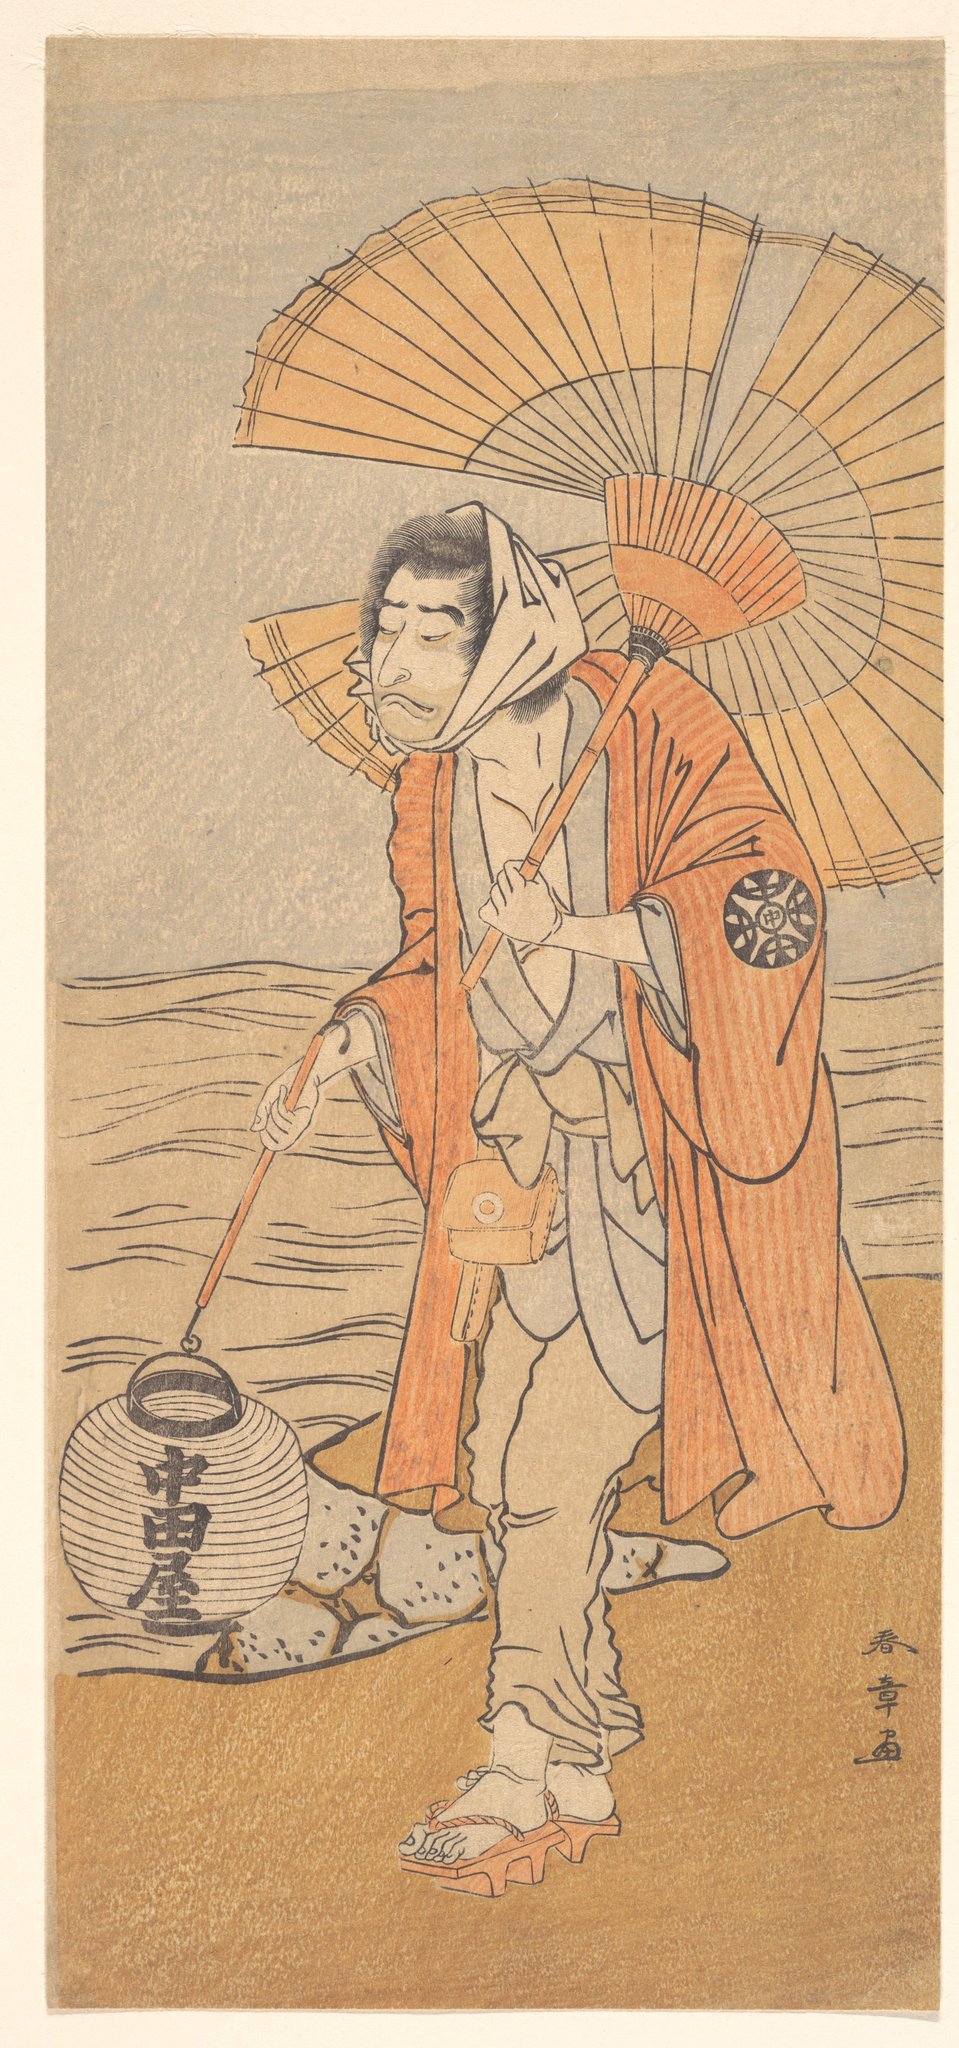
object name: woodblock print nishiki e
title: The Actor Nakamura Nakazo I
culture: japanese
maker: katsukawa shunshō 勝川春章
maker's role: artist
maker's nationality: japanese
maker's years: 1726-1792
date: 1775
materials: ink, paper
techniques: nishiki e, woodblock print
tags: men,actors